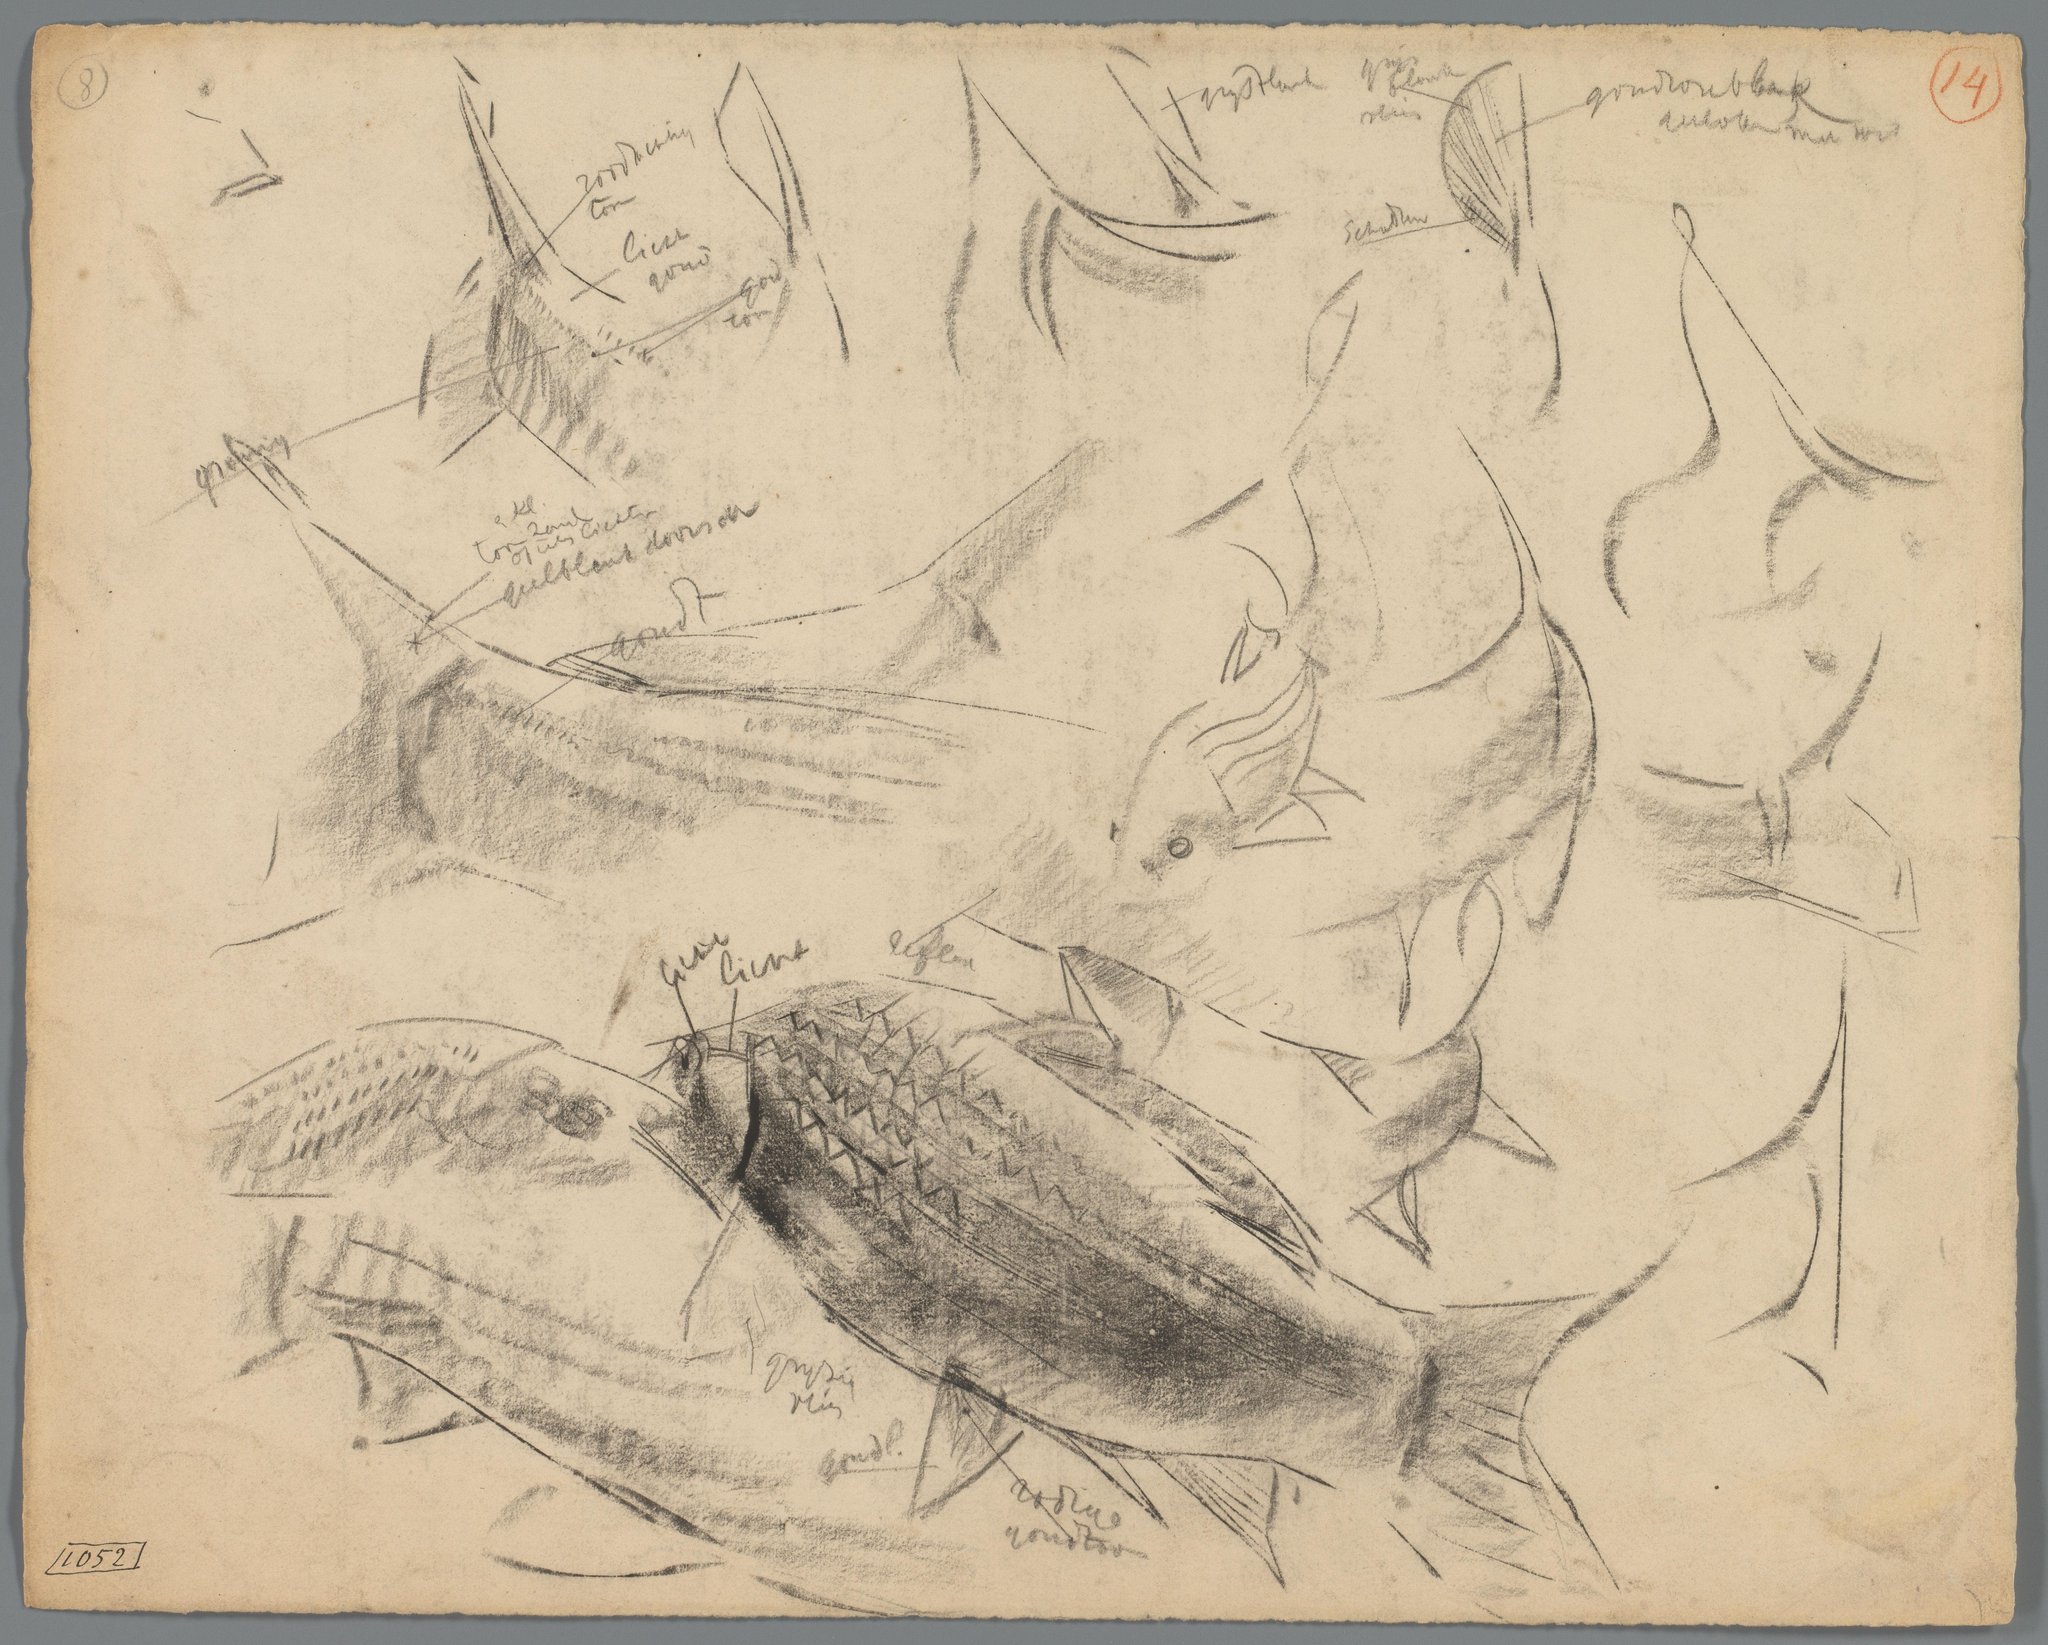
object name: drawing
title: Studies van karpers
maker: gerrit willem dijsselhof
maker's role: designer, draughtsman, print maker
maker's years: 1866-1924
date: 1876-1924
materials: chalk, paper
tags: bony fishes: carp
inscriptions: number: ‘1052’